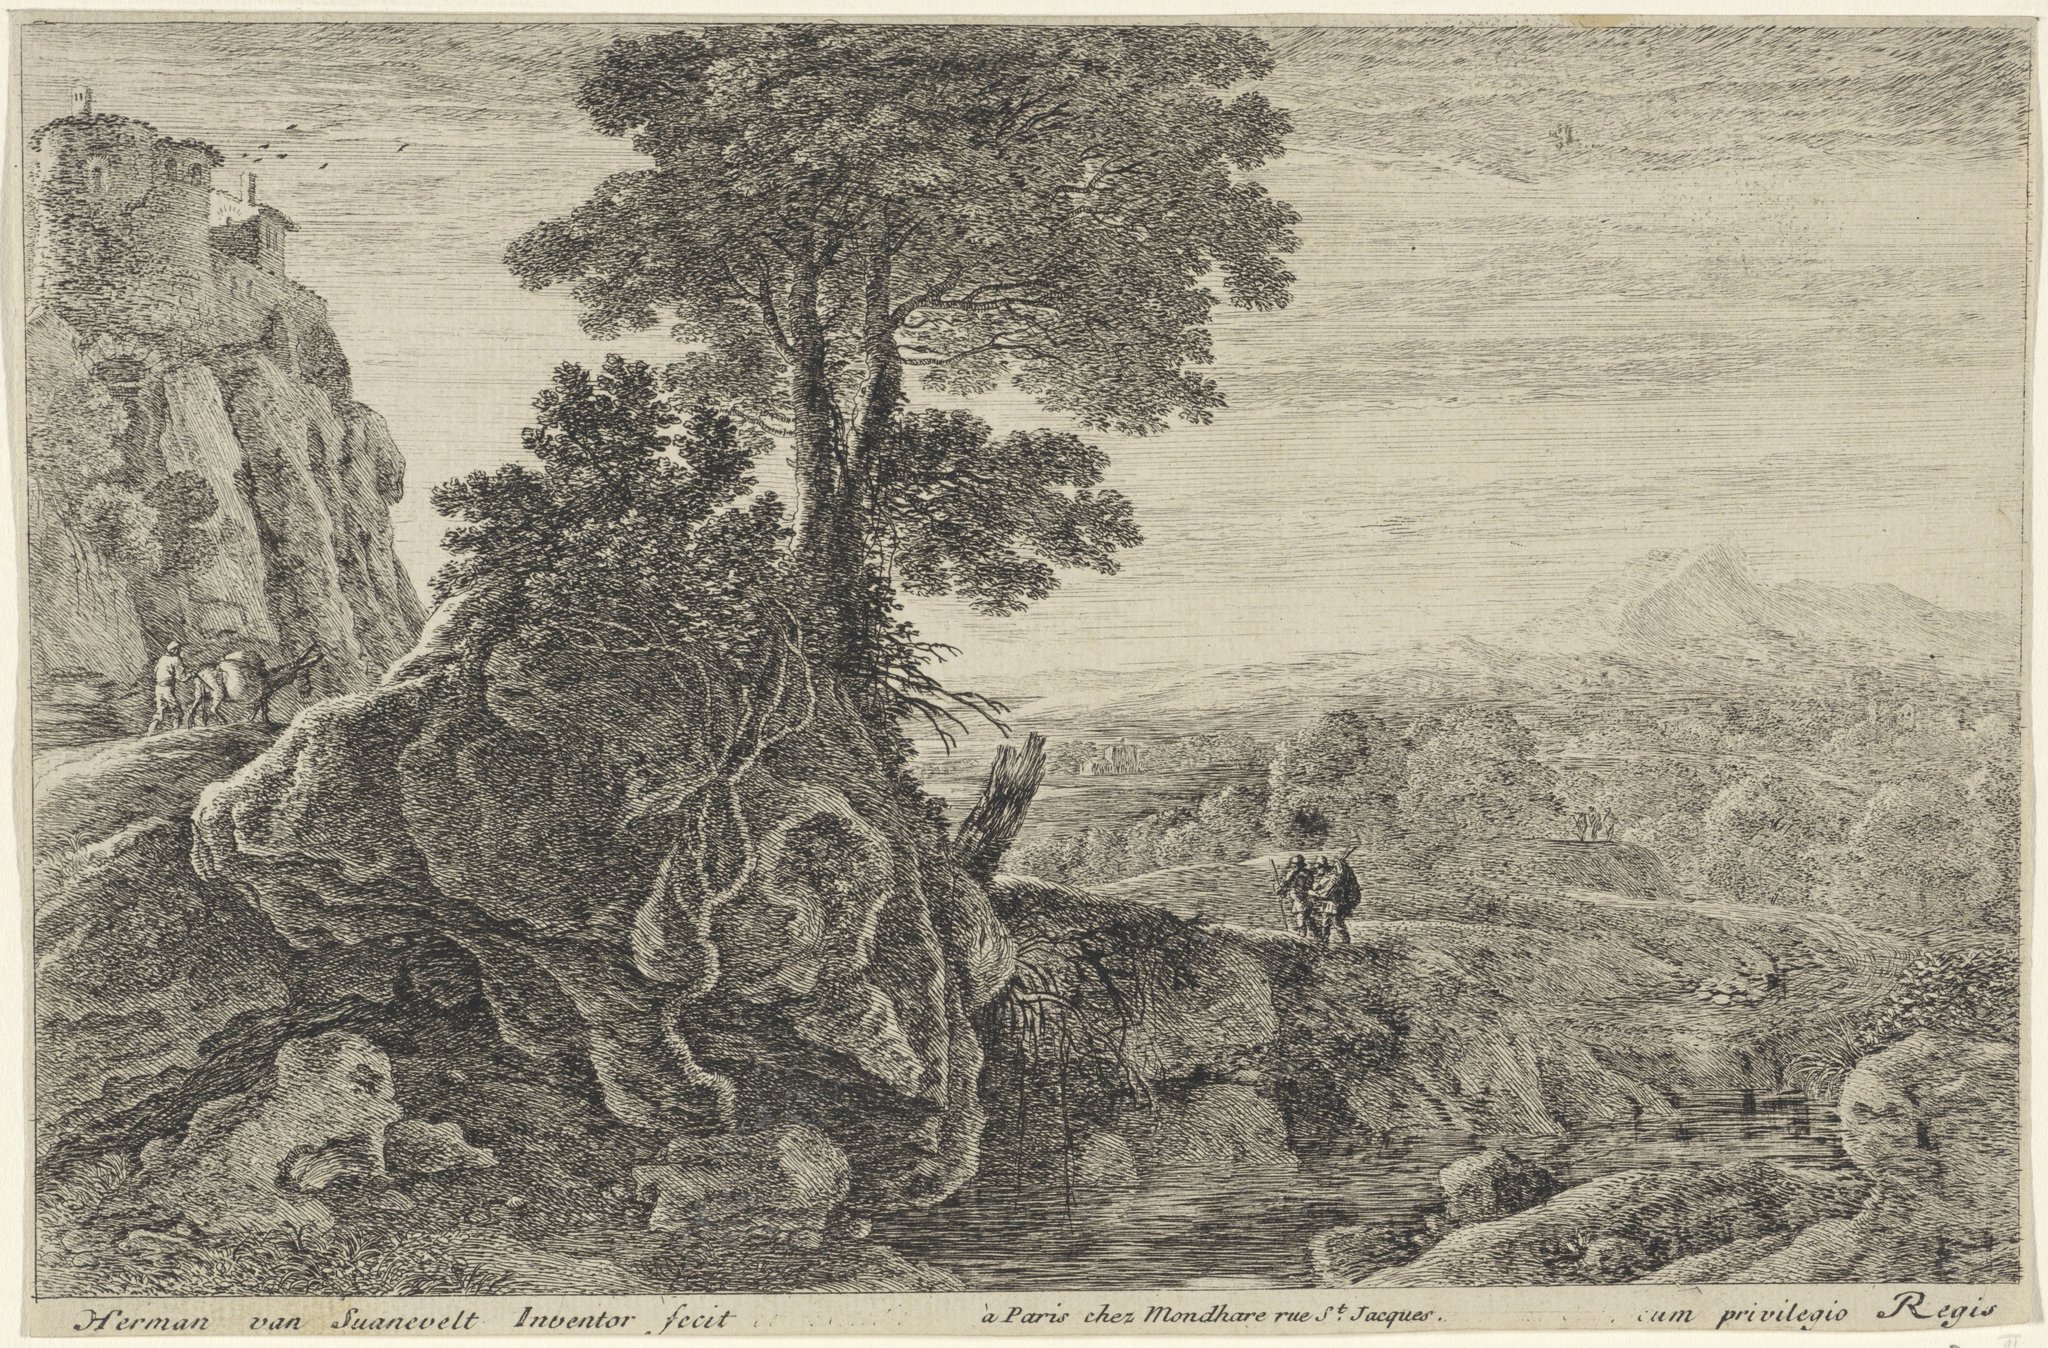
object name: print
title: Landschap met een gebouw op een rots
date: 1759-1784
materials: paper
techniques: etching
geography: paris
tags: riding a horse, ass, or mule; rider, horseman, landscapes, ass, donkey, river, rural housing, e.g. country-house, villa, cottage, (high) hill, brook, 'en route', traveller under way, rocks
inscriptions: collector's mark: Lugt 2228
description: In de buurt van een groep bomen lopen enkele wandelaars over een pad, van wie een een ezel drijft. Op een hoge rots ligt een versterkt gebouw.